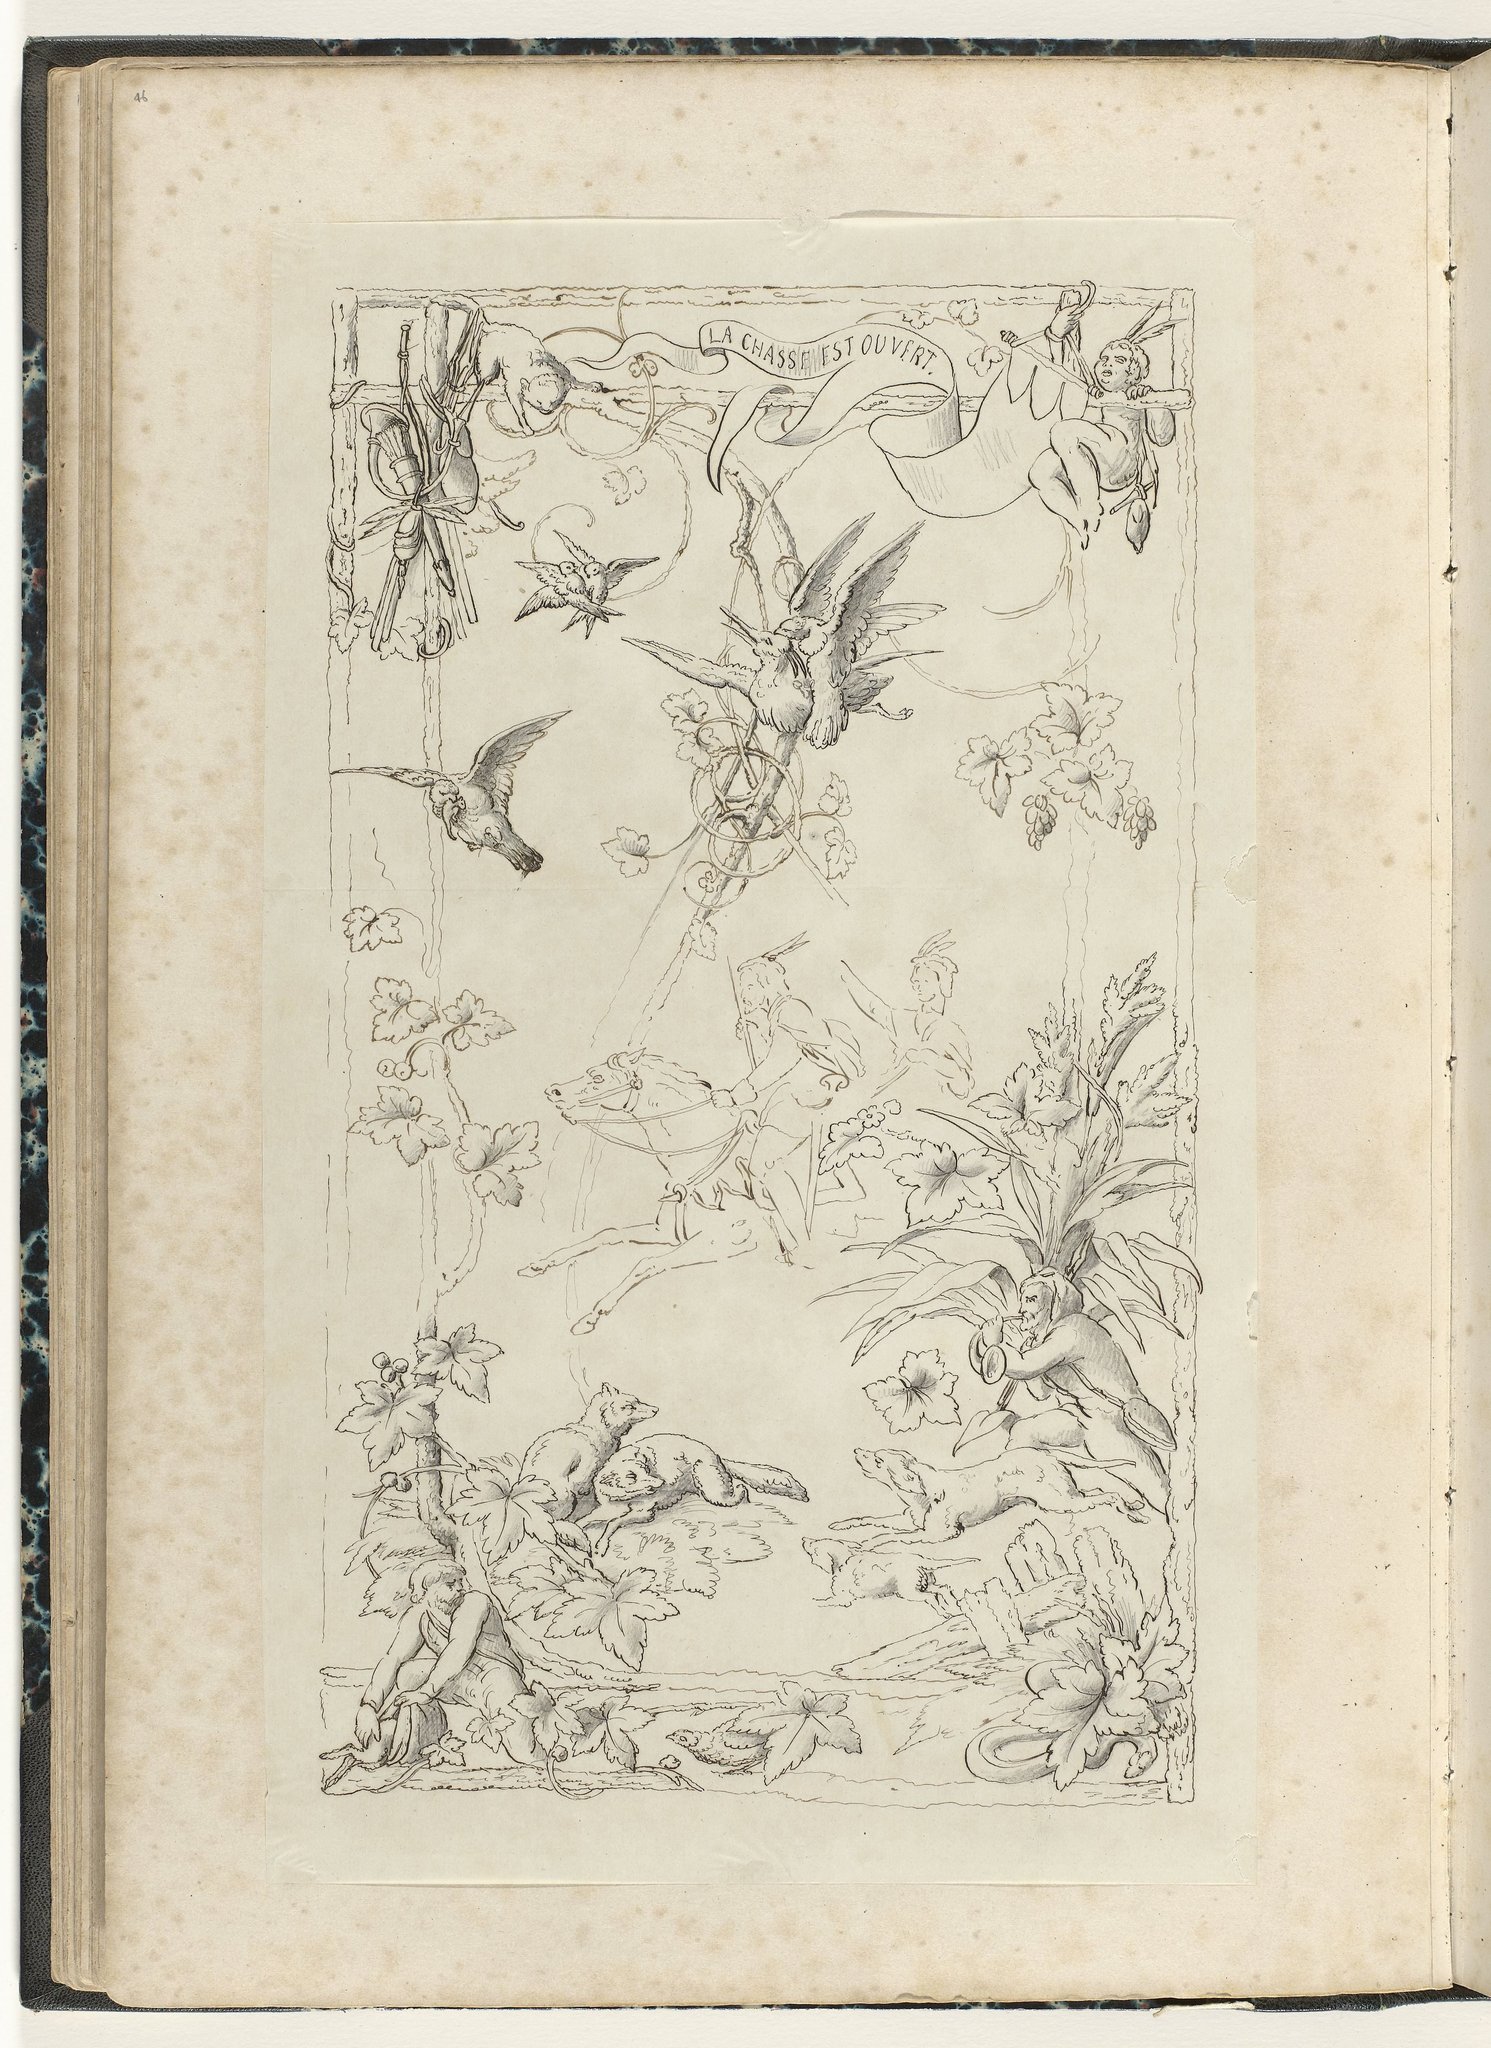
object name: drawing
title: La Chasse est Ouvert.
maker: Anonymous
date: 1866-1900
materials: ink, pencil, paper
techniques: drawing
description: Jachtscènes in een lijst van houten takken. Linksboven hangt een trofee van jachtattributen, linksonder stopt een man een gevangen dier in een zak.